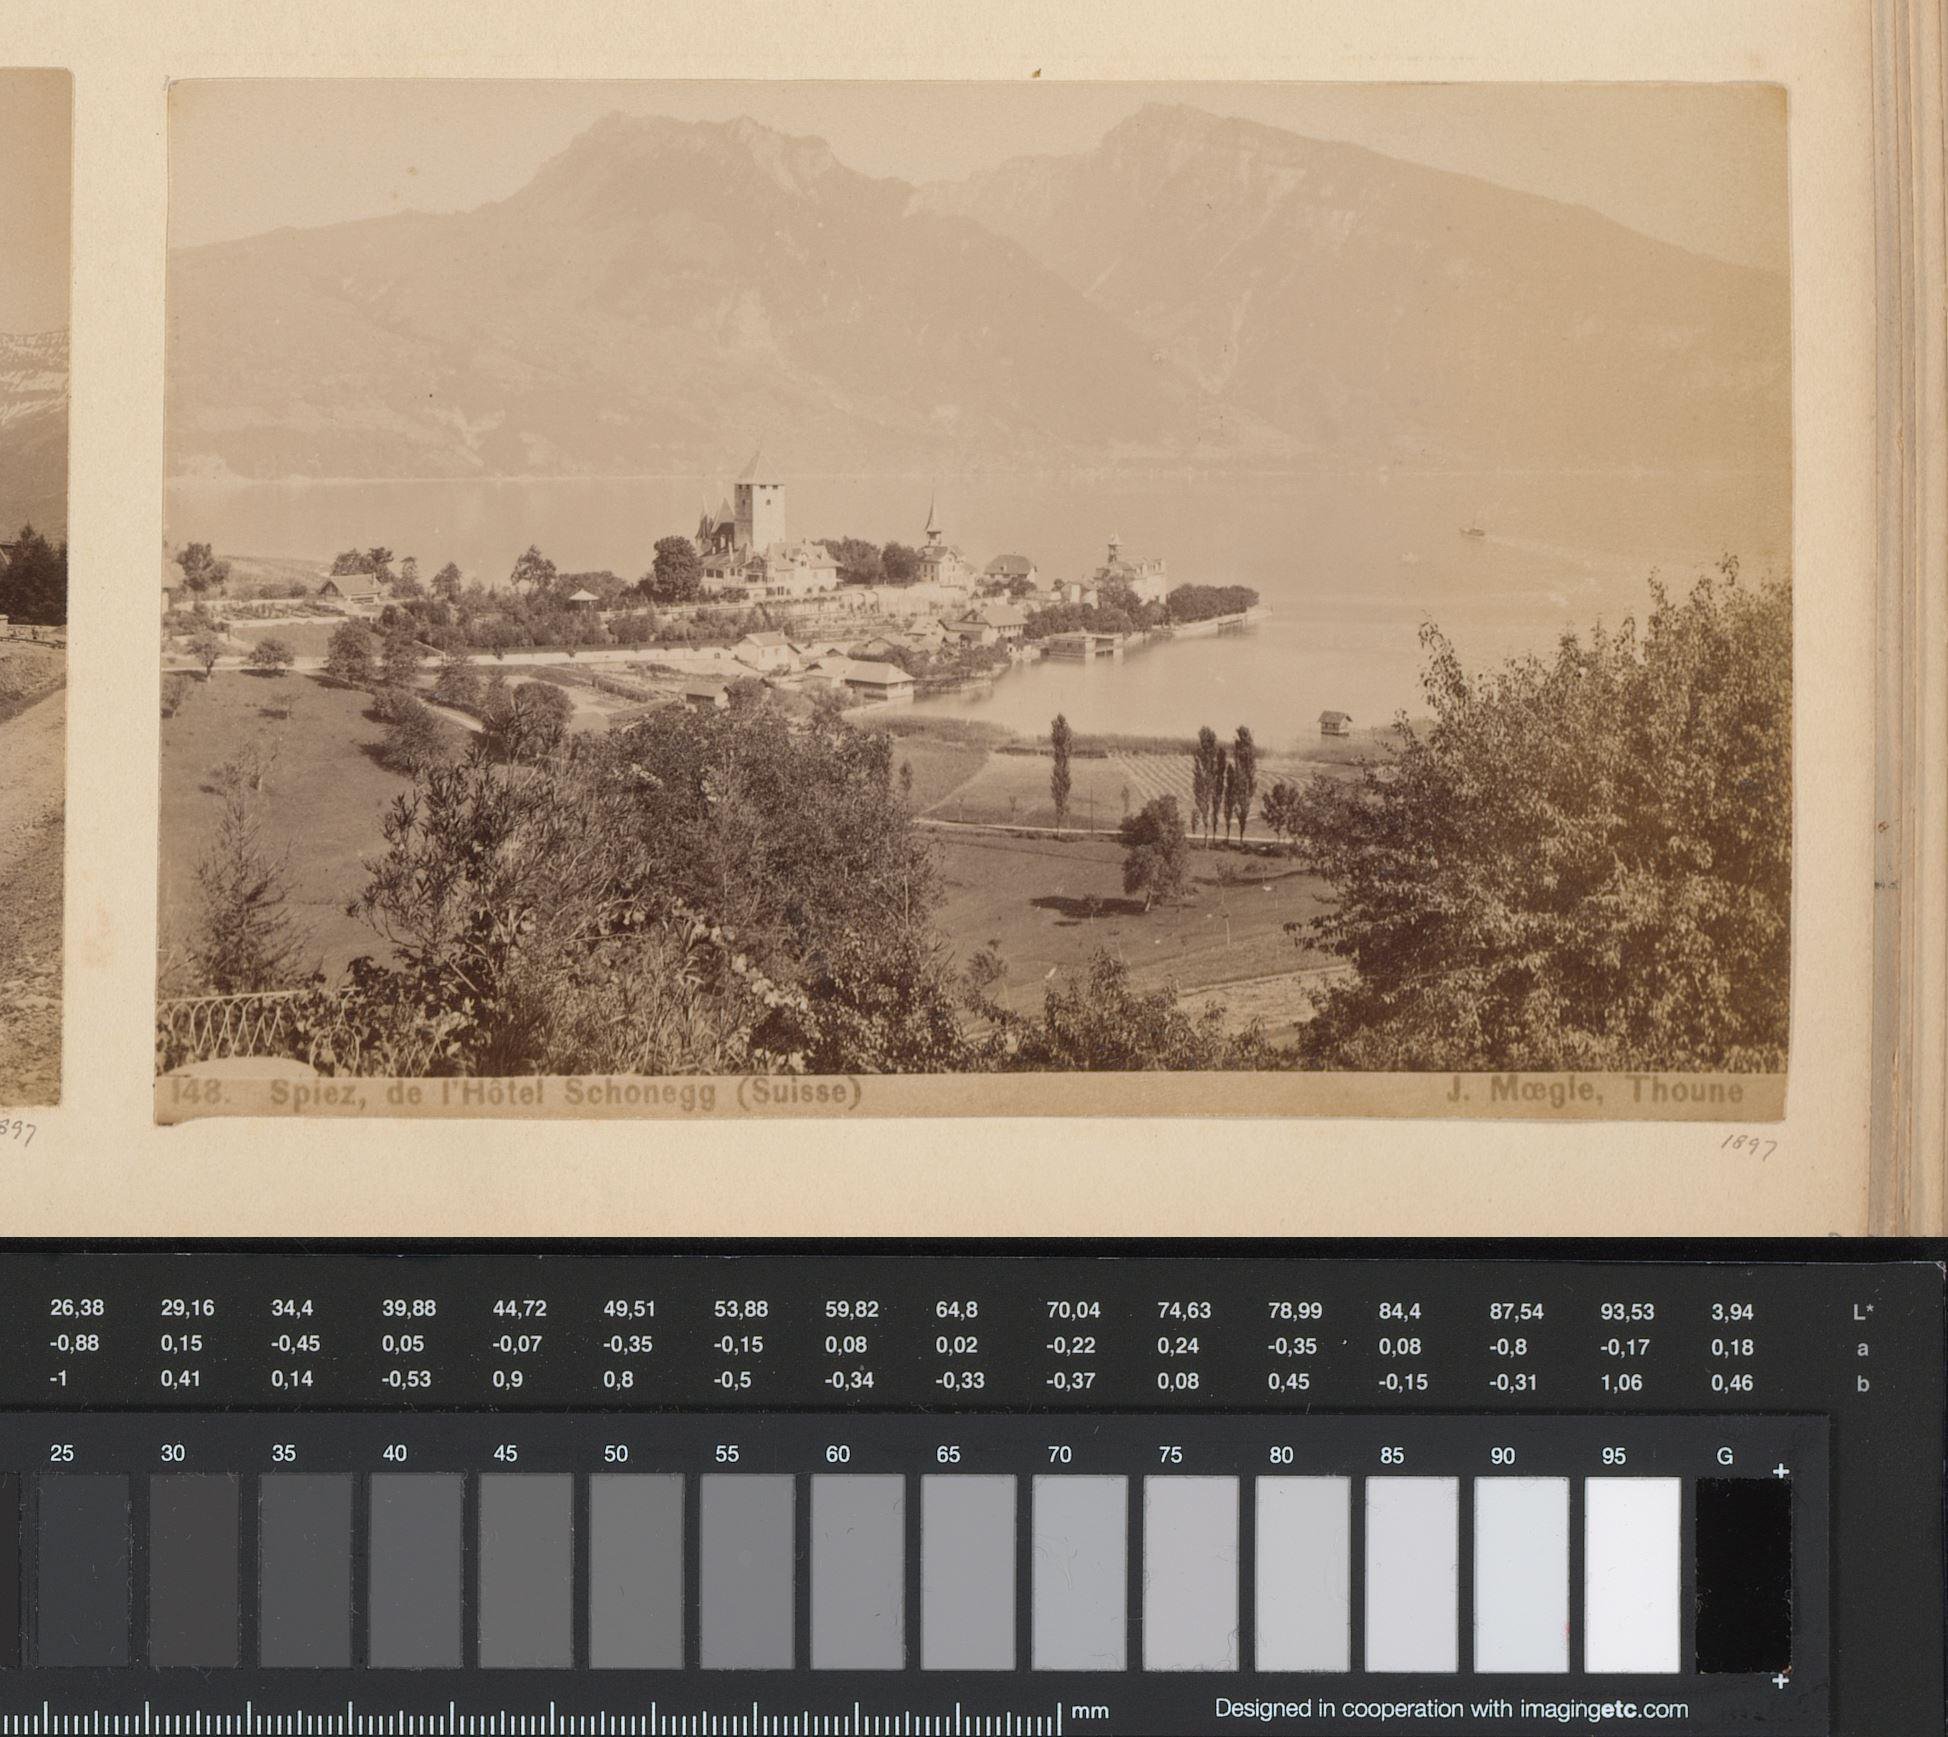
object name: photograph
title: Gezicht op Spiez met de Thunersee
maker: jean moeglé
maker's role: fotograaf, hofleverancier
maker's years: 1853-1938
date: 1897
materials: photographic support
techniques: albumen print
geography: spiez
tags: lake, landscape with tower or castle, city-view in general; 'veduta' (+ city(-scape) with figures, staffage)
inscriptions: annotation: ‘1897’, inscription: ‘148. Spiez, de l'Hôtel Schonegg (Suisse)/ J. Moegle, Thoune’